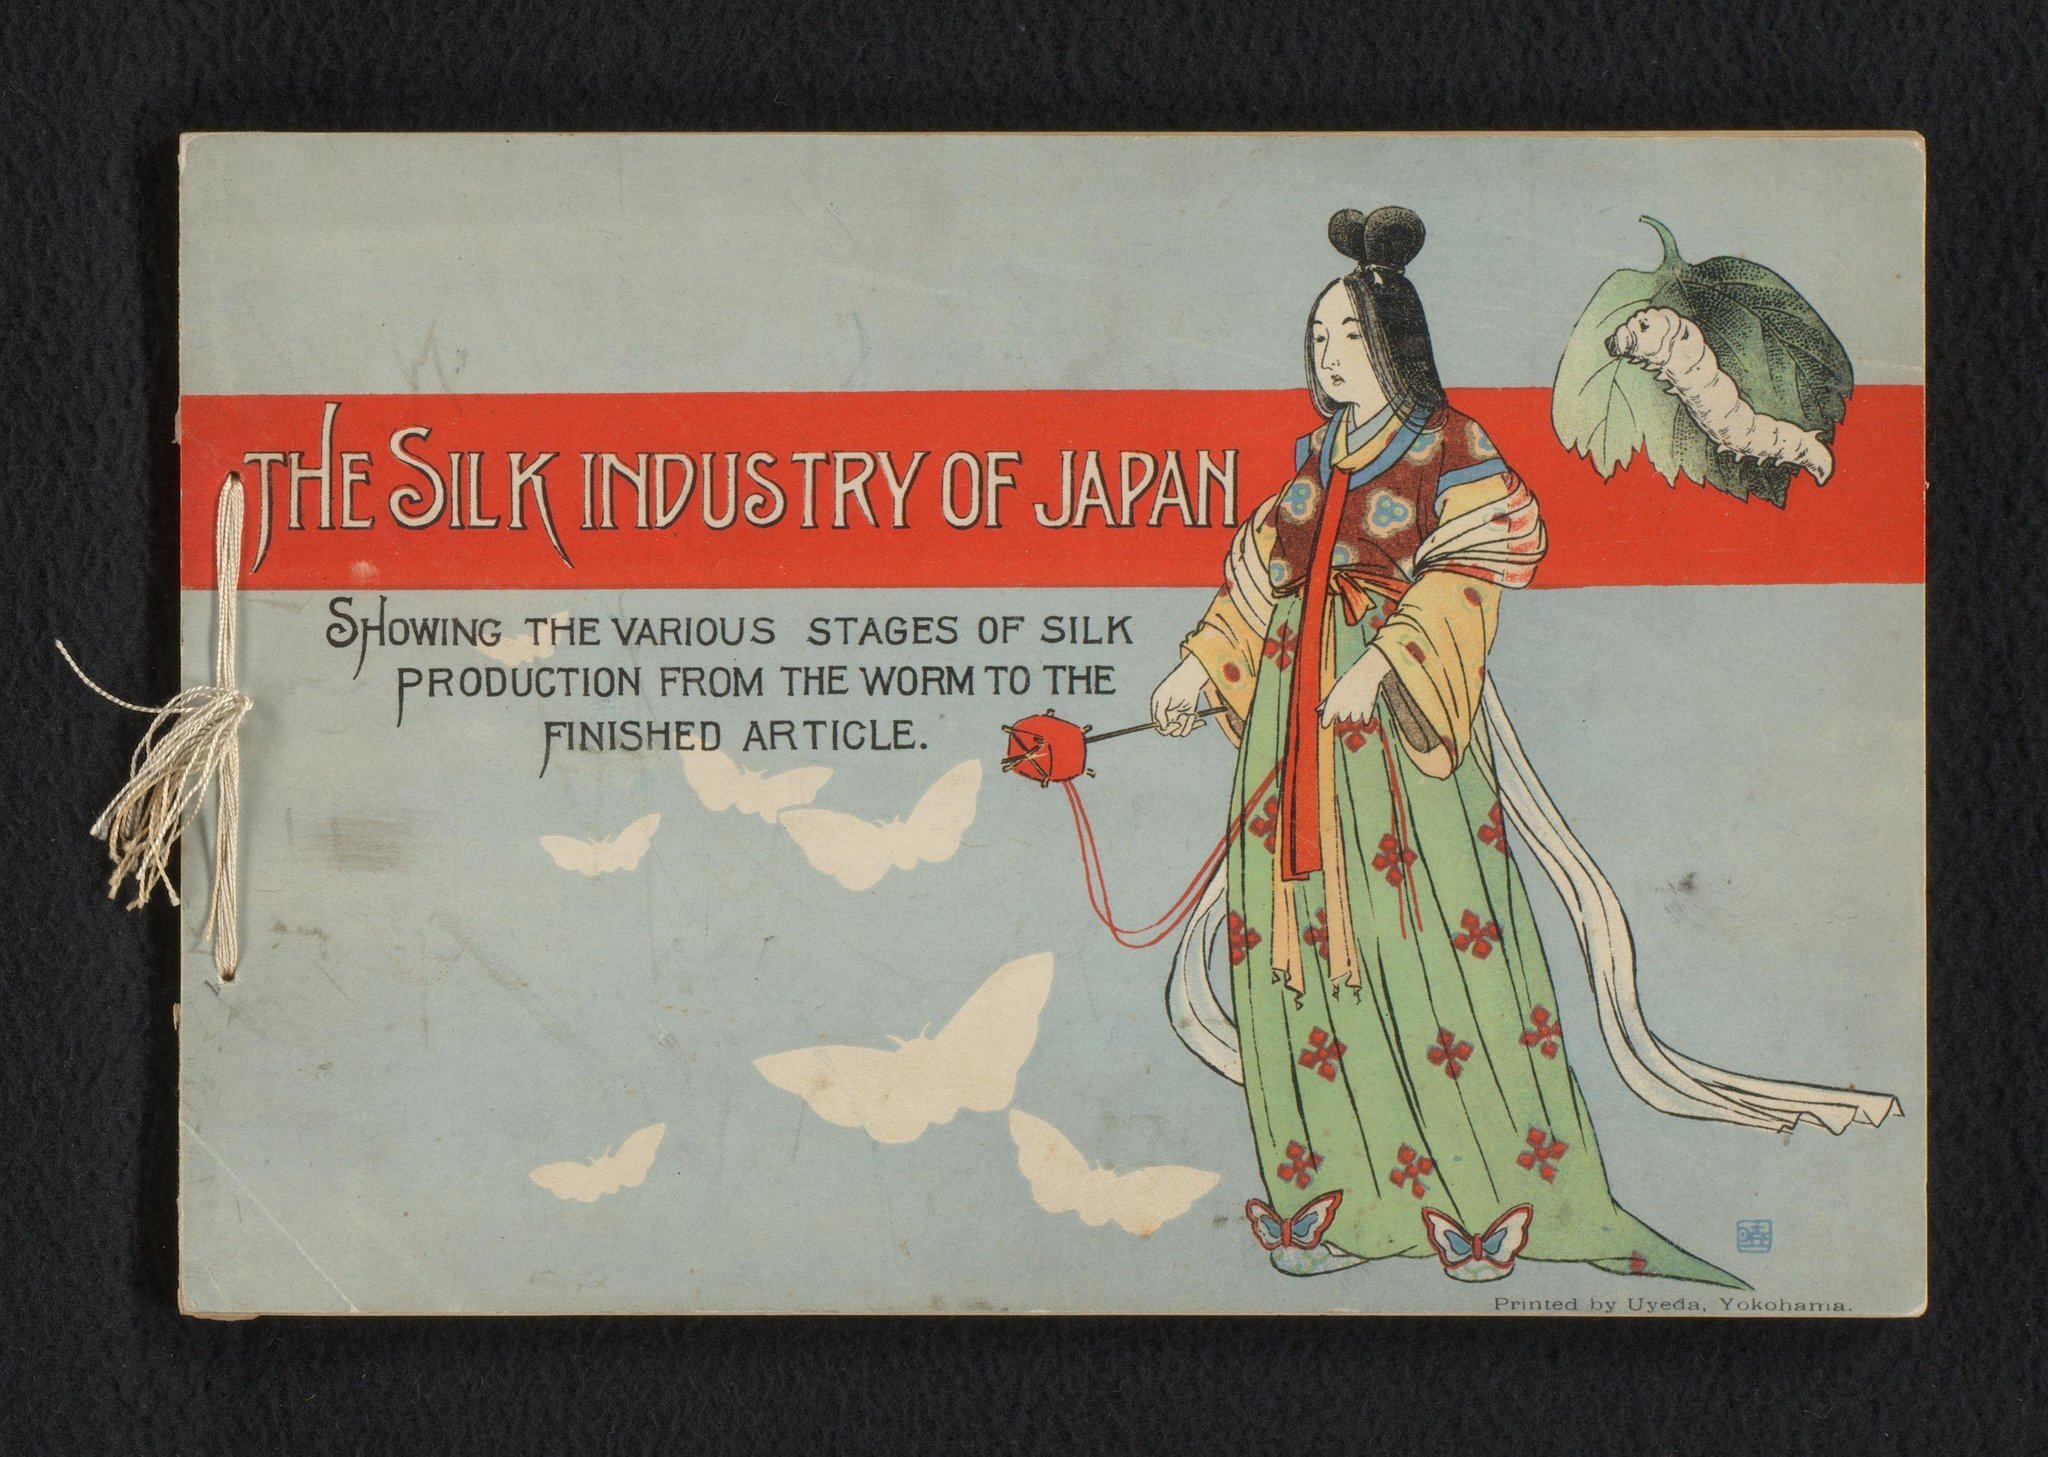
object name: book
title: Showing the various stages of silk production from the worm to the finished article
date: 1890-1910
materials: paper, yarns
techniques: photograph, hand coloring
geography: yokohama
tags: special processes for silk fabric, weaving, silk (material ~ textile industry), japan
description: Boek met 20 handgekleurde lichtdrukken waarop verschillende stadia uit de productieketen van zijde zijn afgebeeld.